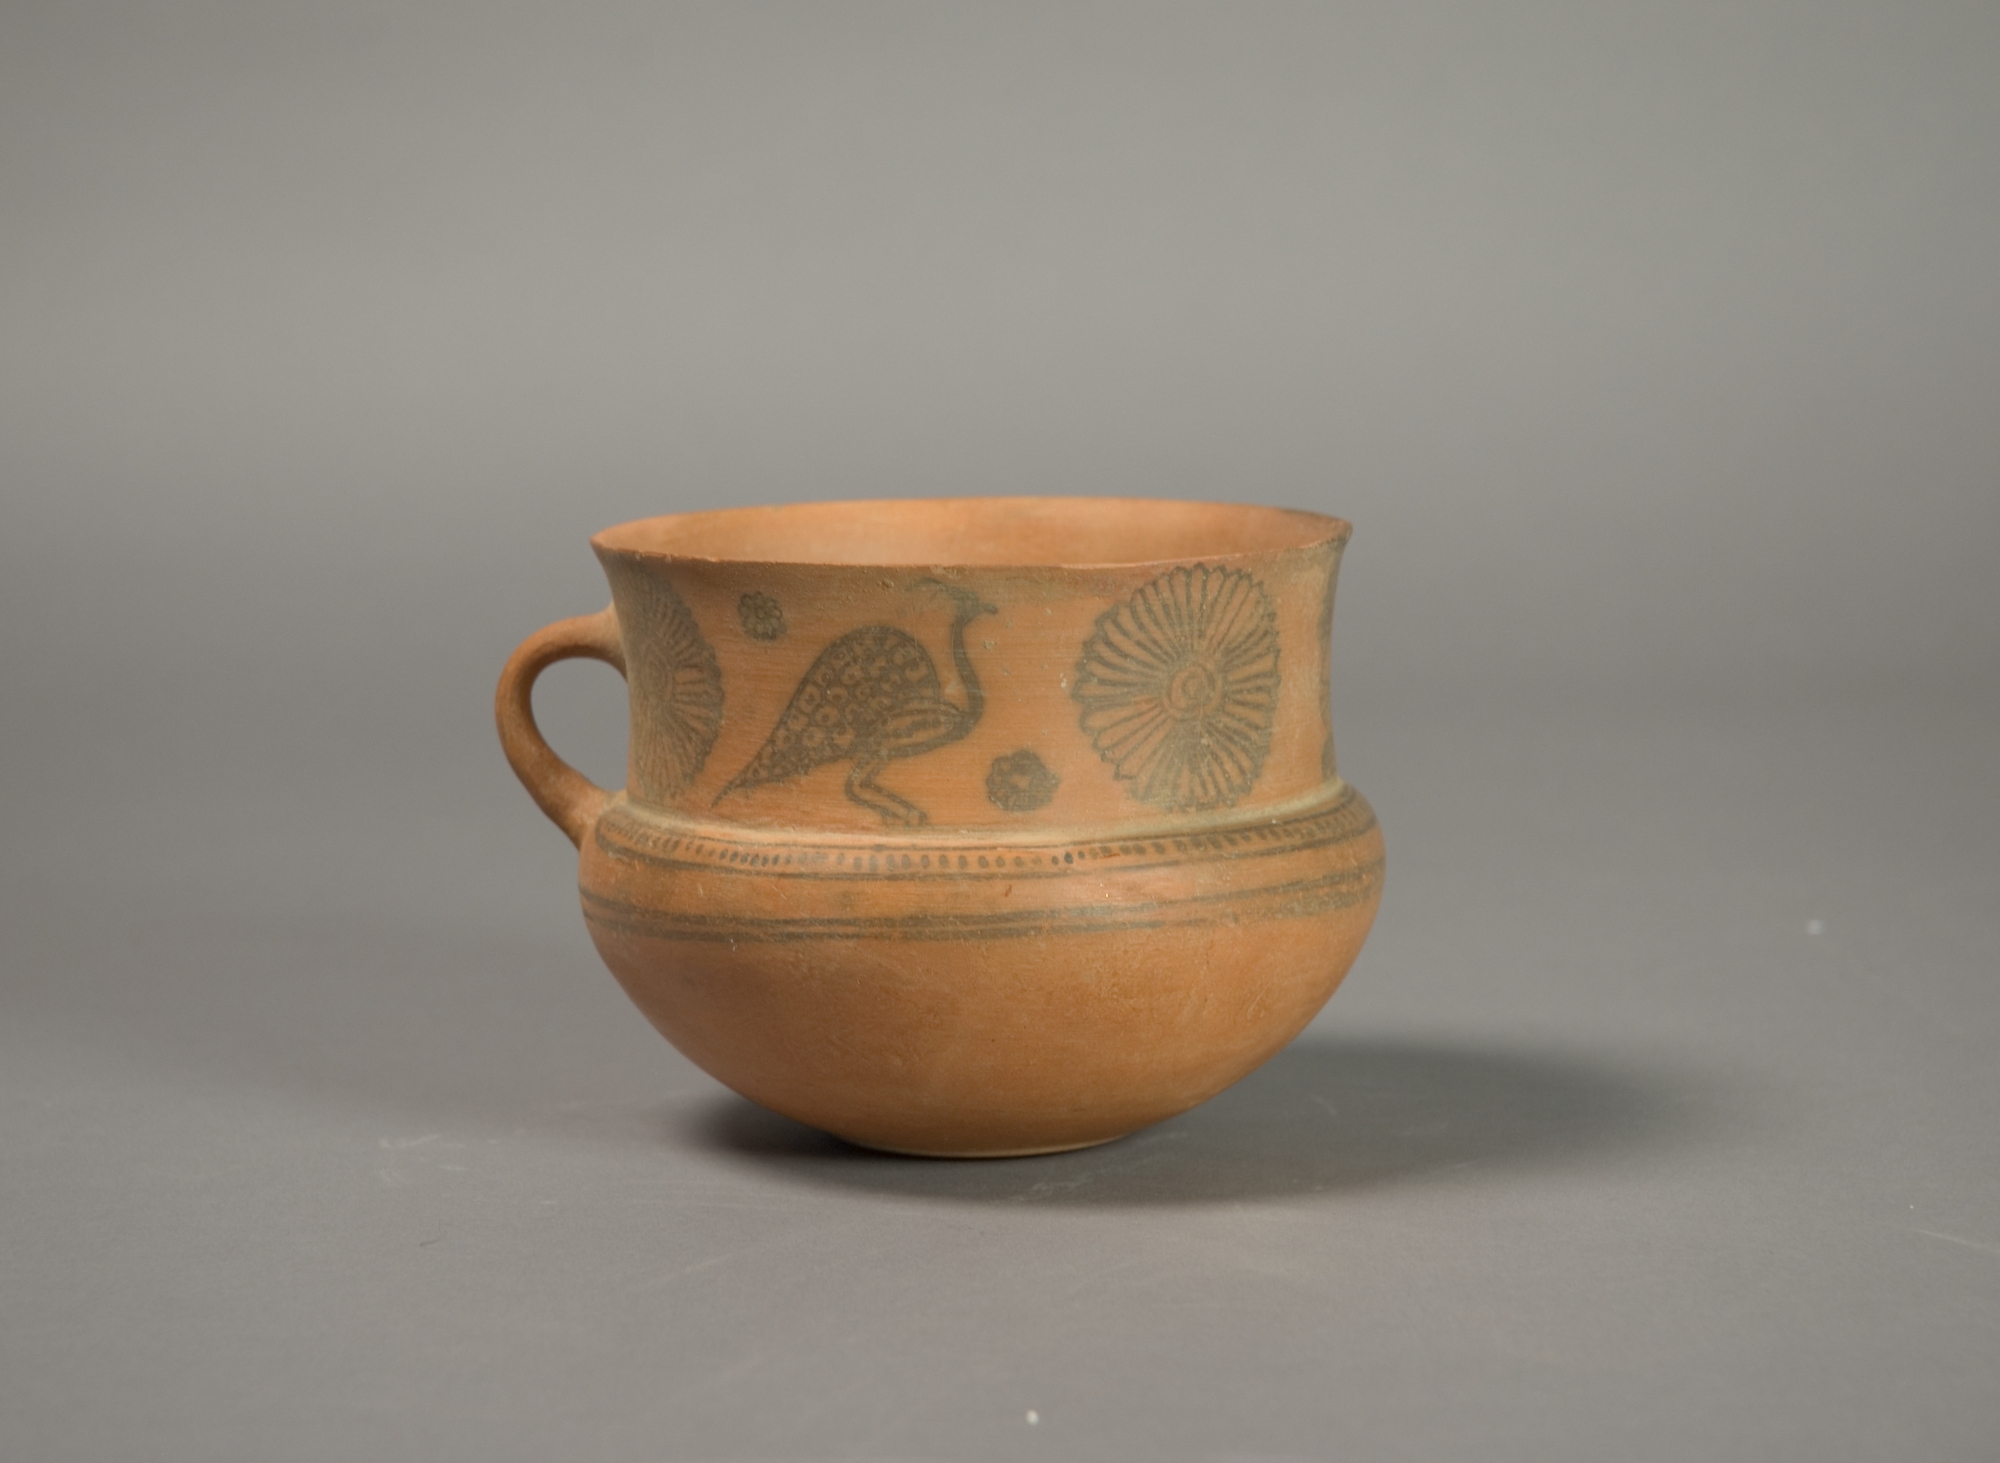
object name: cup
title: Cup with Painted Decoration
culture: pakistani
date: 301-500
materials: terracotta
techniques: painting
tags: gandhara,peacocks,flowers